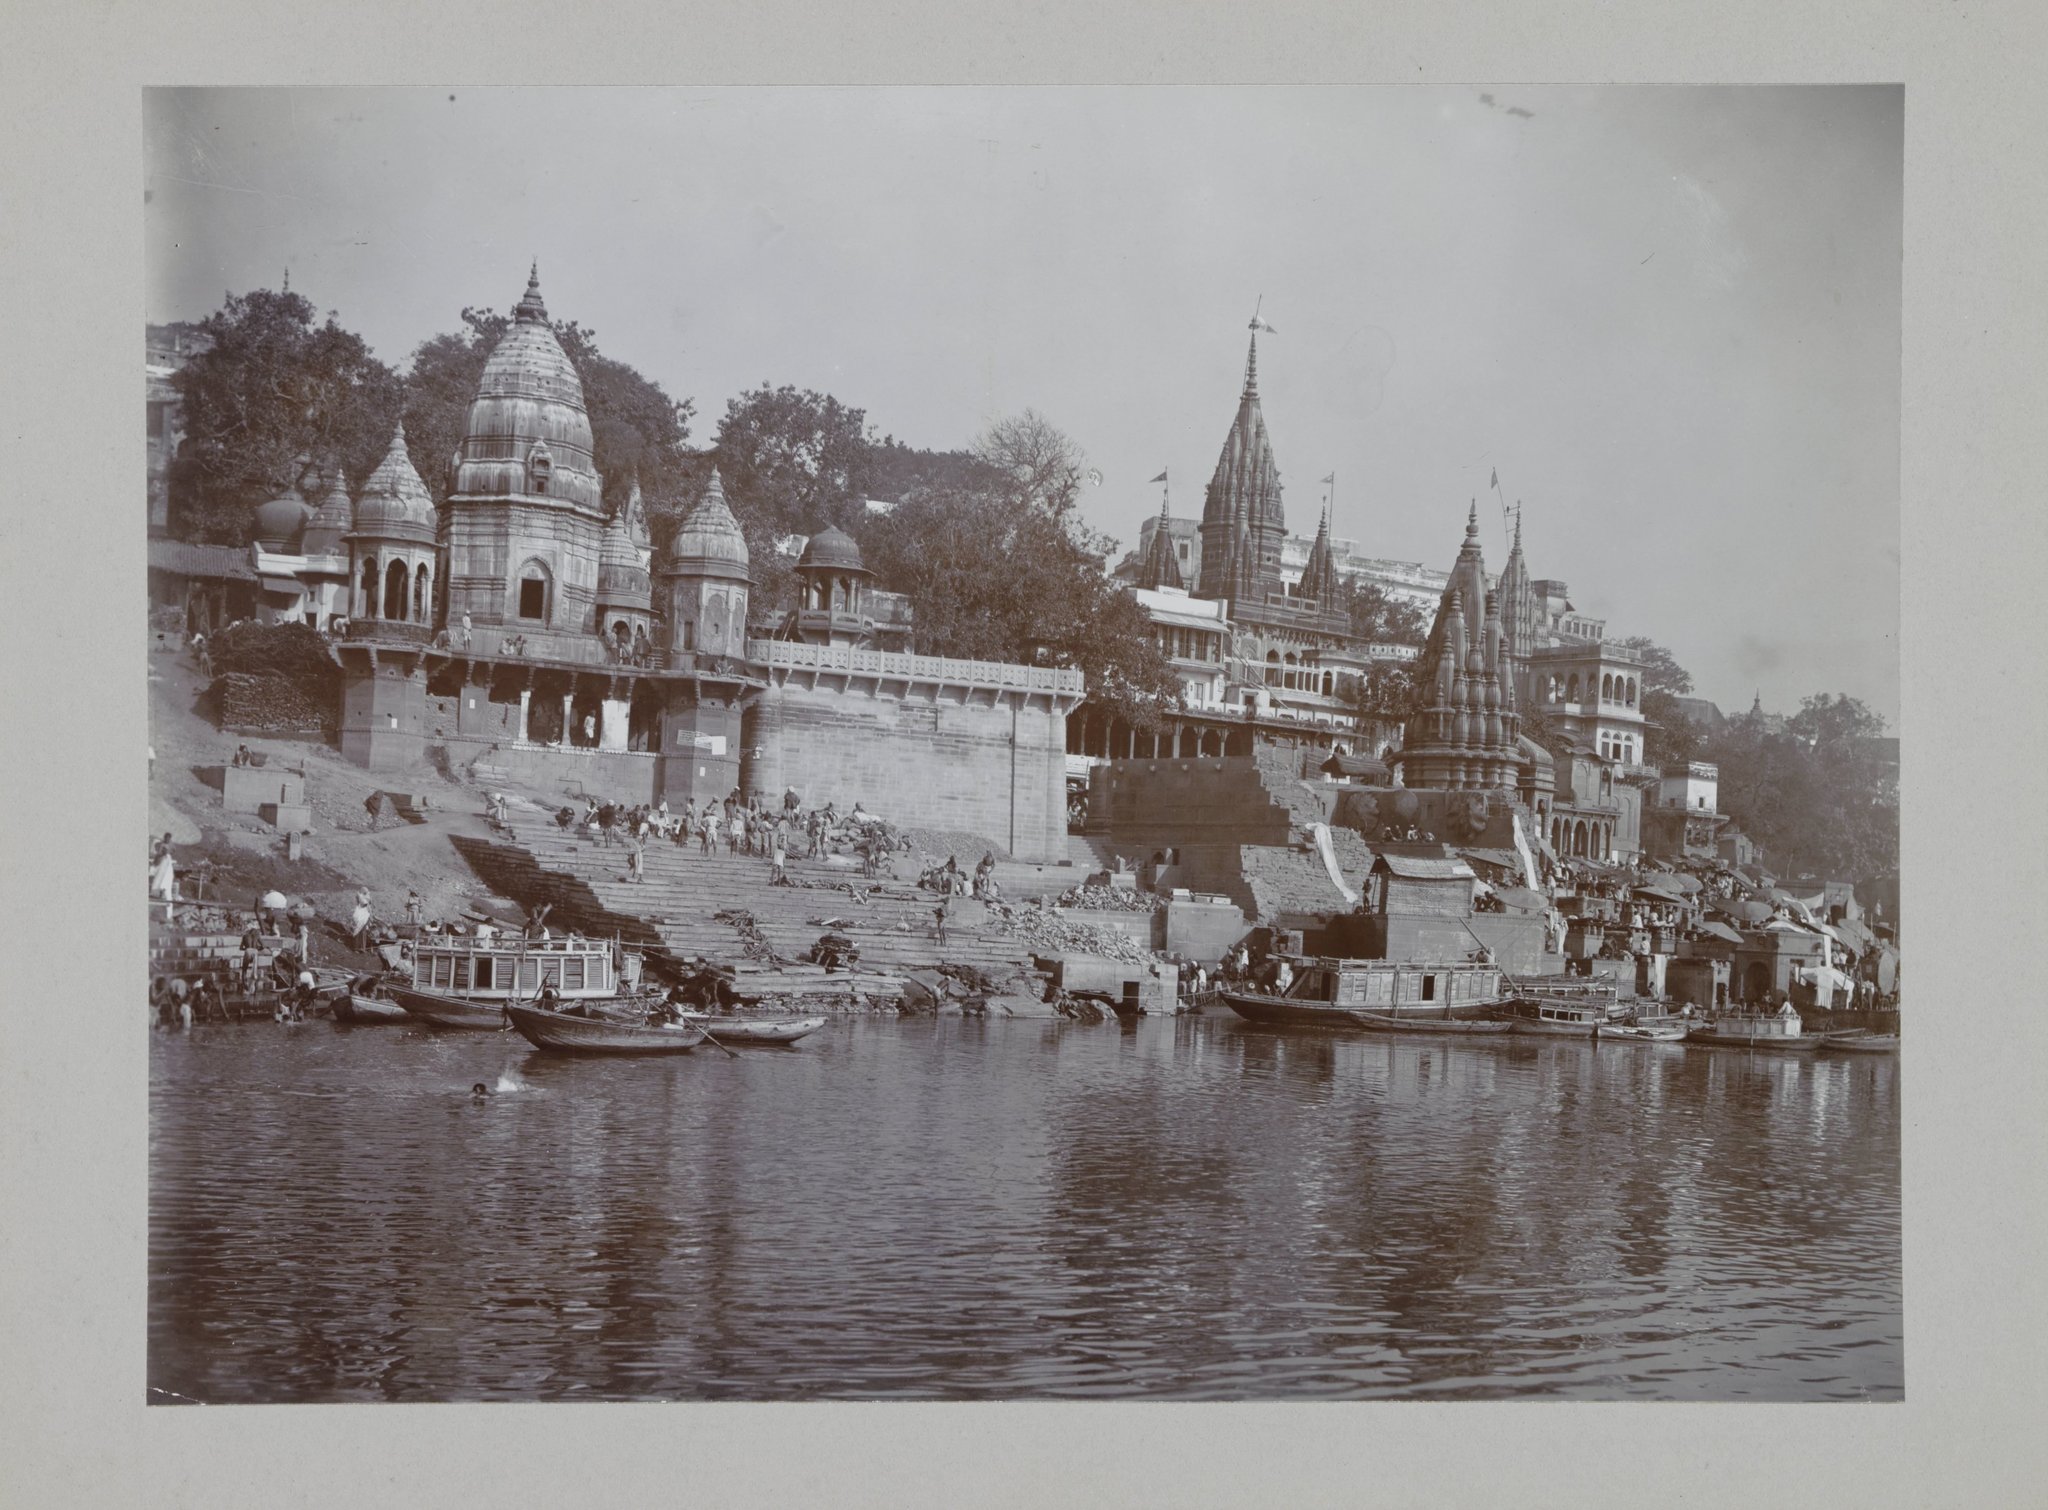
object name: photograph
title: View of the temples by the Ganga river at Varanasi, Uttar Pradesh, India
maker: Anonymous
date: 1895-1915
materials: cardboard, paper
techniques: gelatin silver print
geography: varanasi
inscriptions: annotation: ‘6. Benares.’